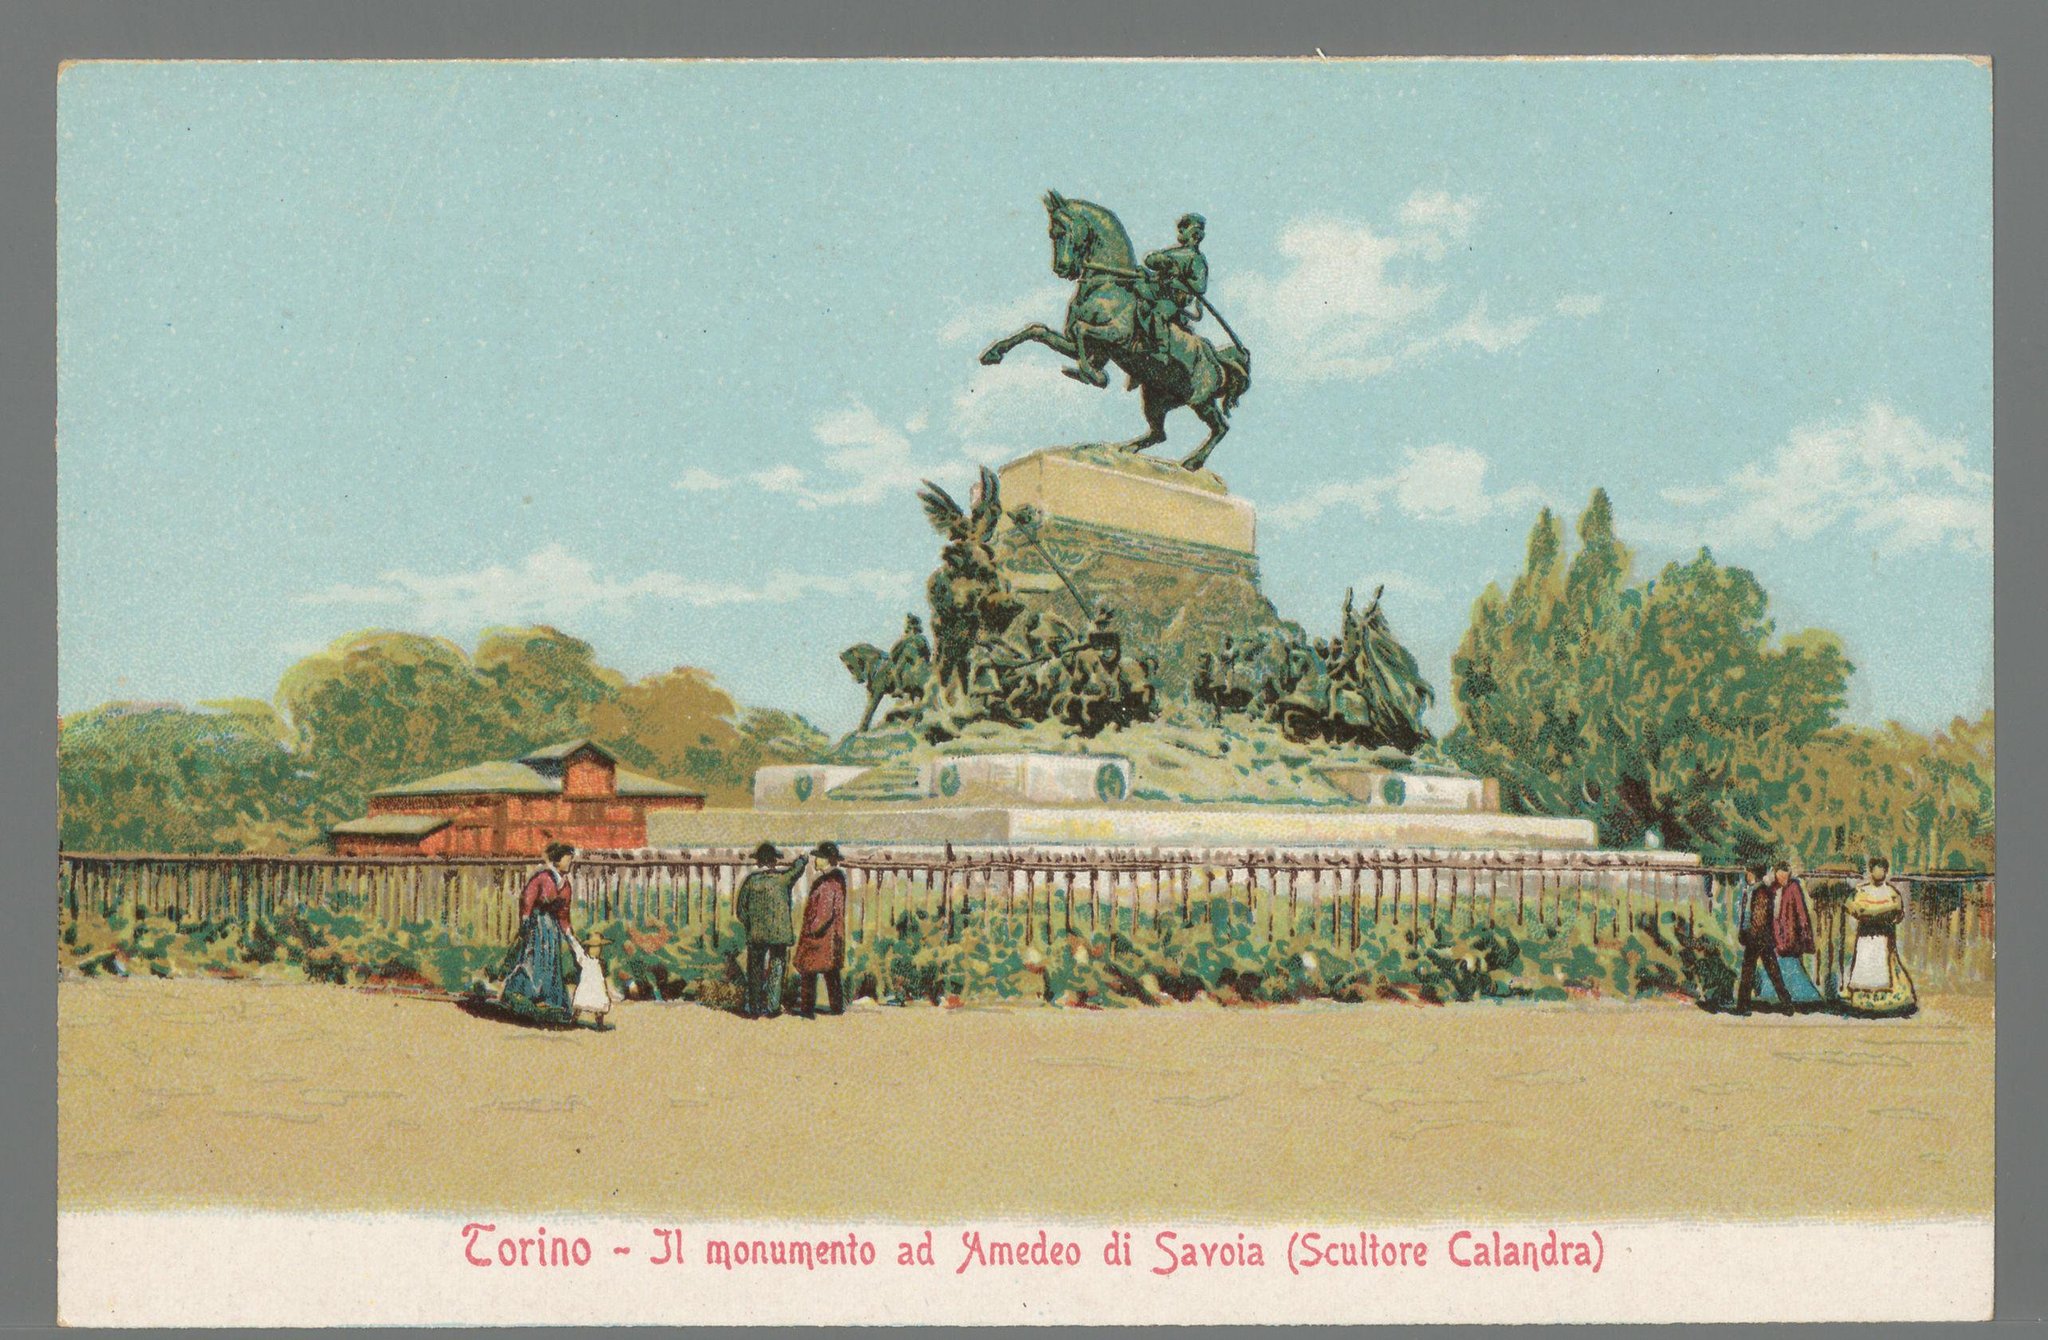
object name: ansichtkaart, prentbriefkaart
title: Torino. Il monumento ad Amedeo di Savoia (Scultore Calandra)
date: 1906-1920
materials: cardboard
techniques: lithograph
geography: venice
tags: public gardens, park (+ city(-scape) with figures, staffage), monument, statue